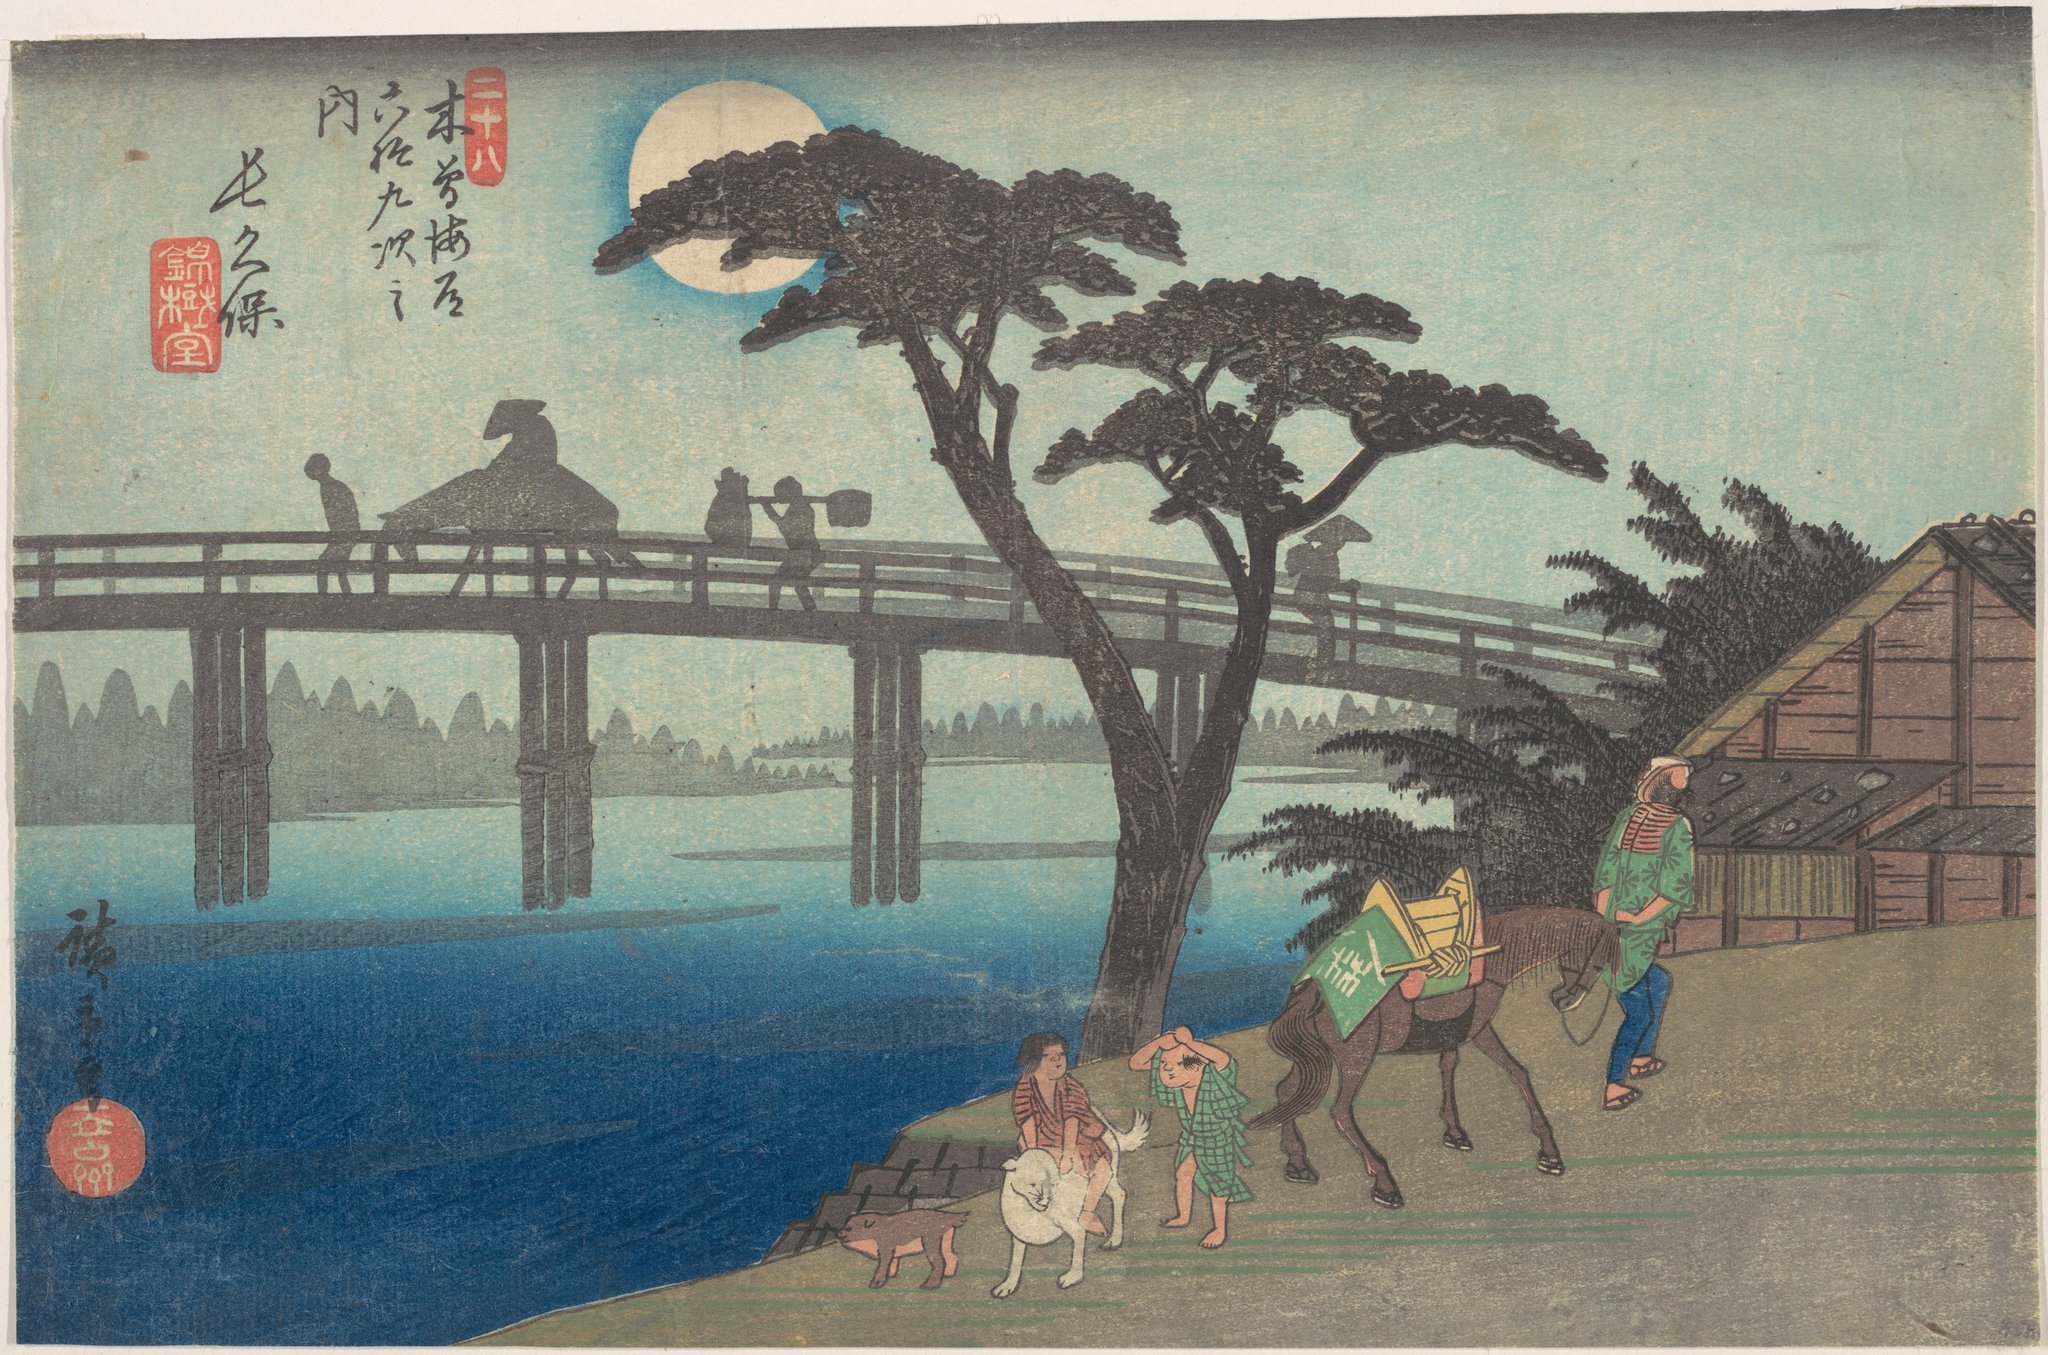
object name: print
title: Nagakubo, Station No. 28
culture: japanese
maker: utagawa hiroshige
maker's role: artist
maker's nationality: japanese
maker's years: 1797-1858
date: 1797-1858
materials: ink, paper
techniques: woodblock print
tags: human figures,bridges,horses,trees